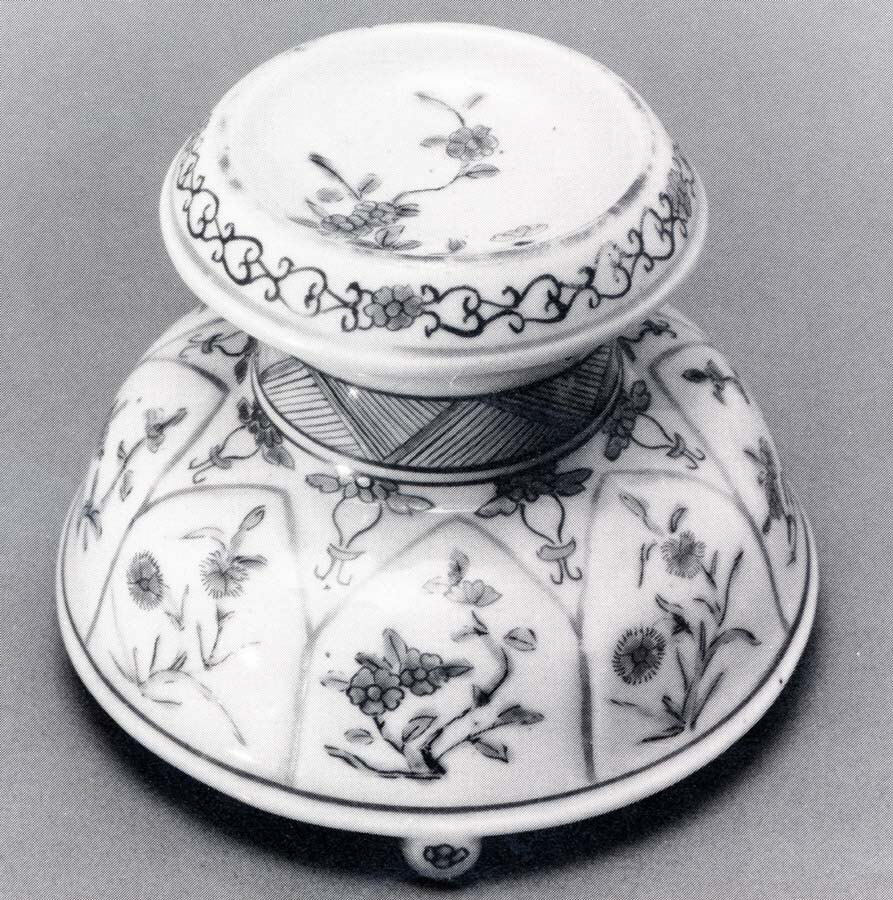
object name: saltcellar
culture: japanese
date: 1680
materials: enamel, gold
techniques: overglaze, polychrome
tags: flowers